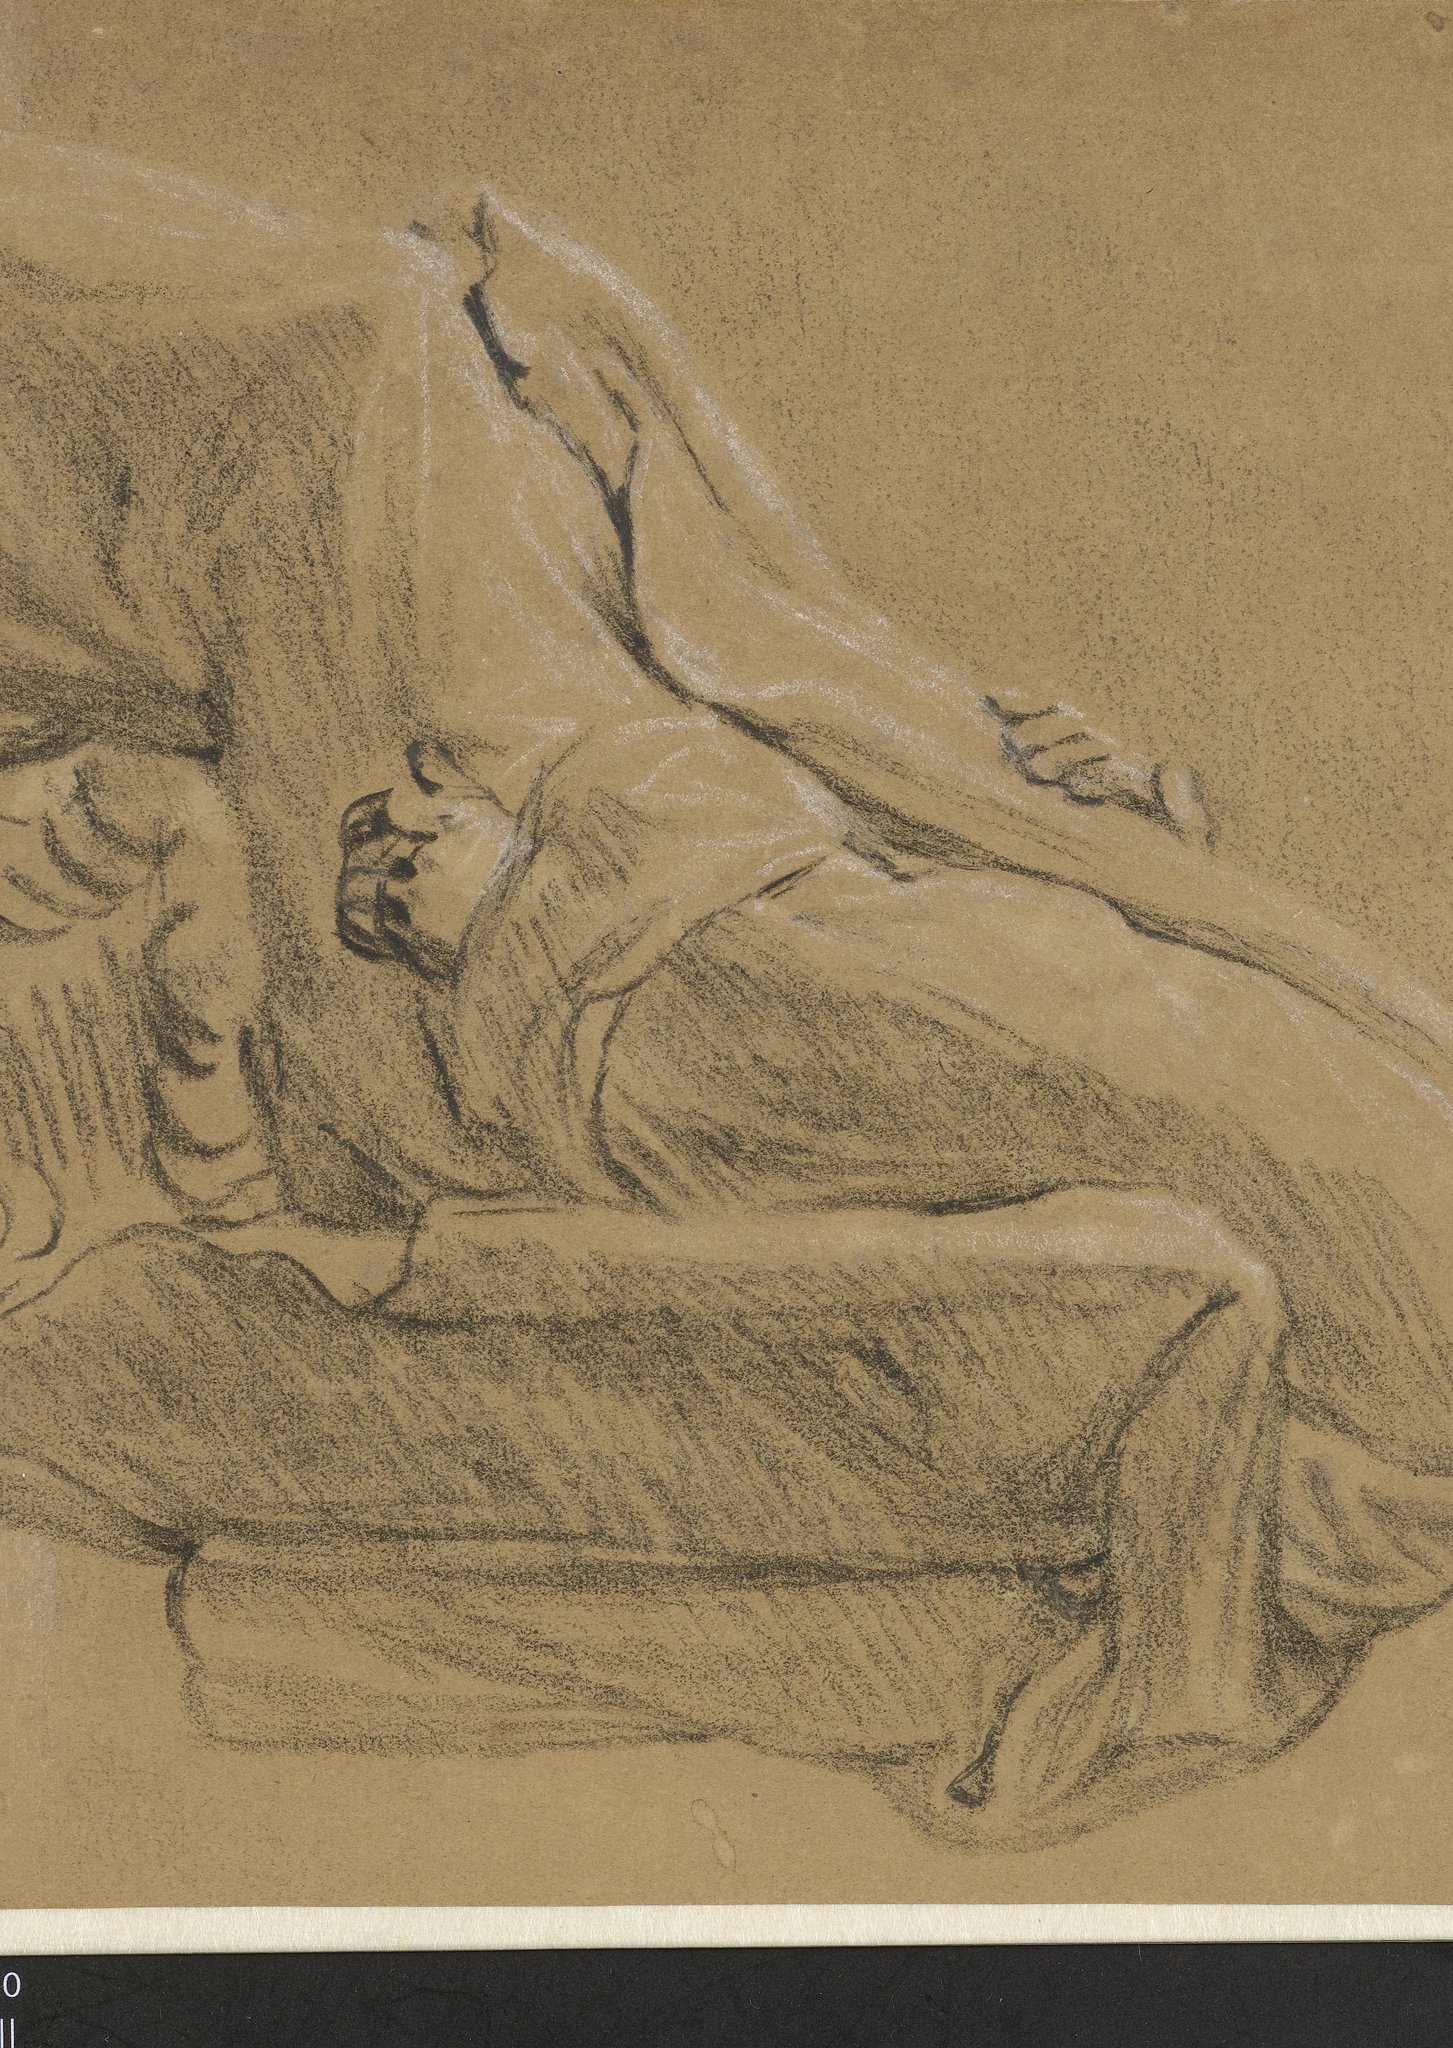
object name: drawing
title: Man Turned to the Left, Seated on a Decoratively Carved Chair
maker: cornelis saftleven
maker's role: draughtsman, painter, print maker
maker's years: 1607-1681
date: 1660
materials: chalk, paint, paper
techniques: drawing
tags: sitting figure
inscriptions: date: ‘1660’